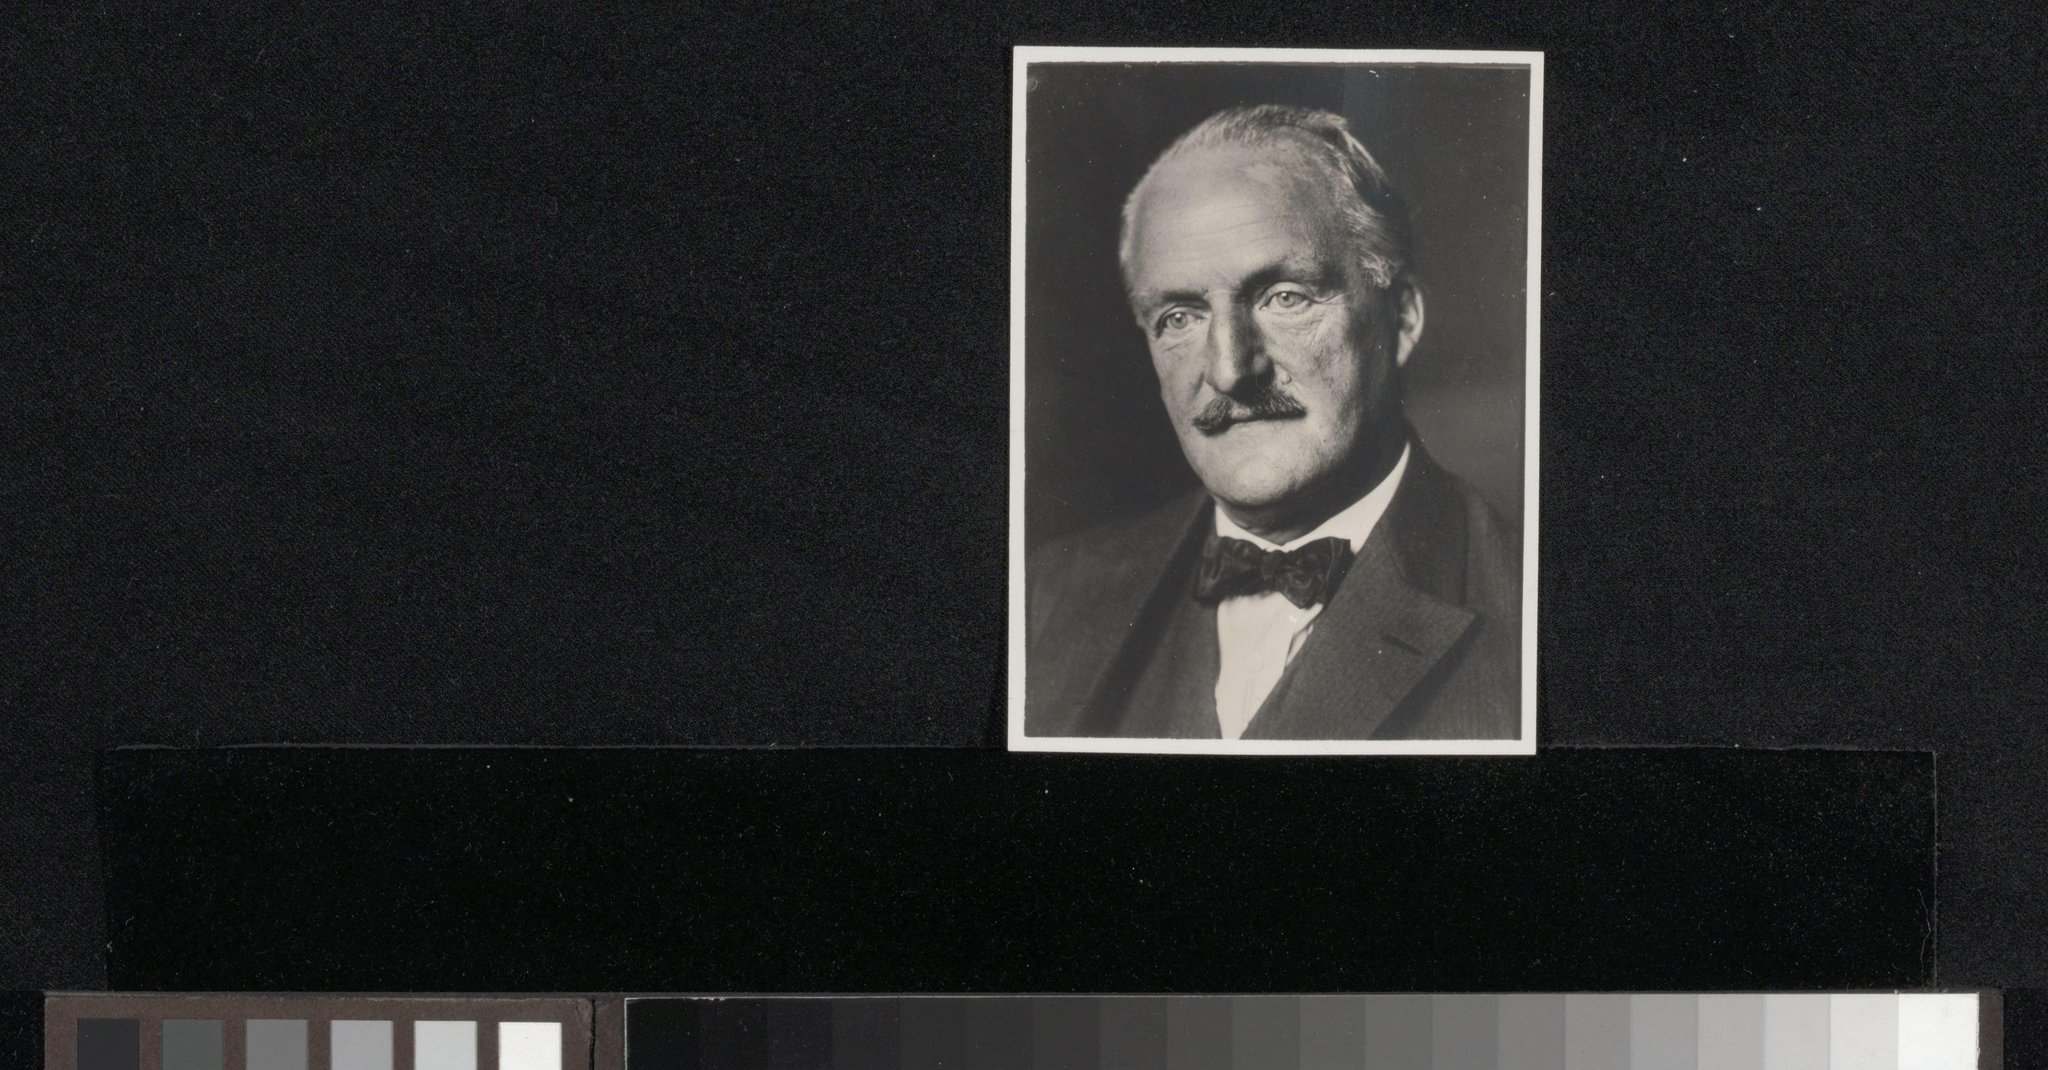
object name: photograph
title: Foto archief Jan Veth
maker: Anonymous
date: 1900-1938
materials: photographic support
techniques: gelatin silver print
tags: dordrecht, amsterdam, painter, print maker, draughtsman, designer, jan veth, richard nicolaüs roland holst, historical persons (portraits and scenes from the life)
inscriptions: collector's mark: ‘RPK’